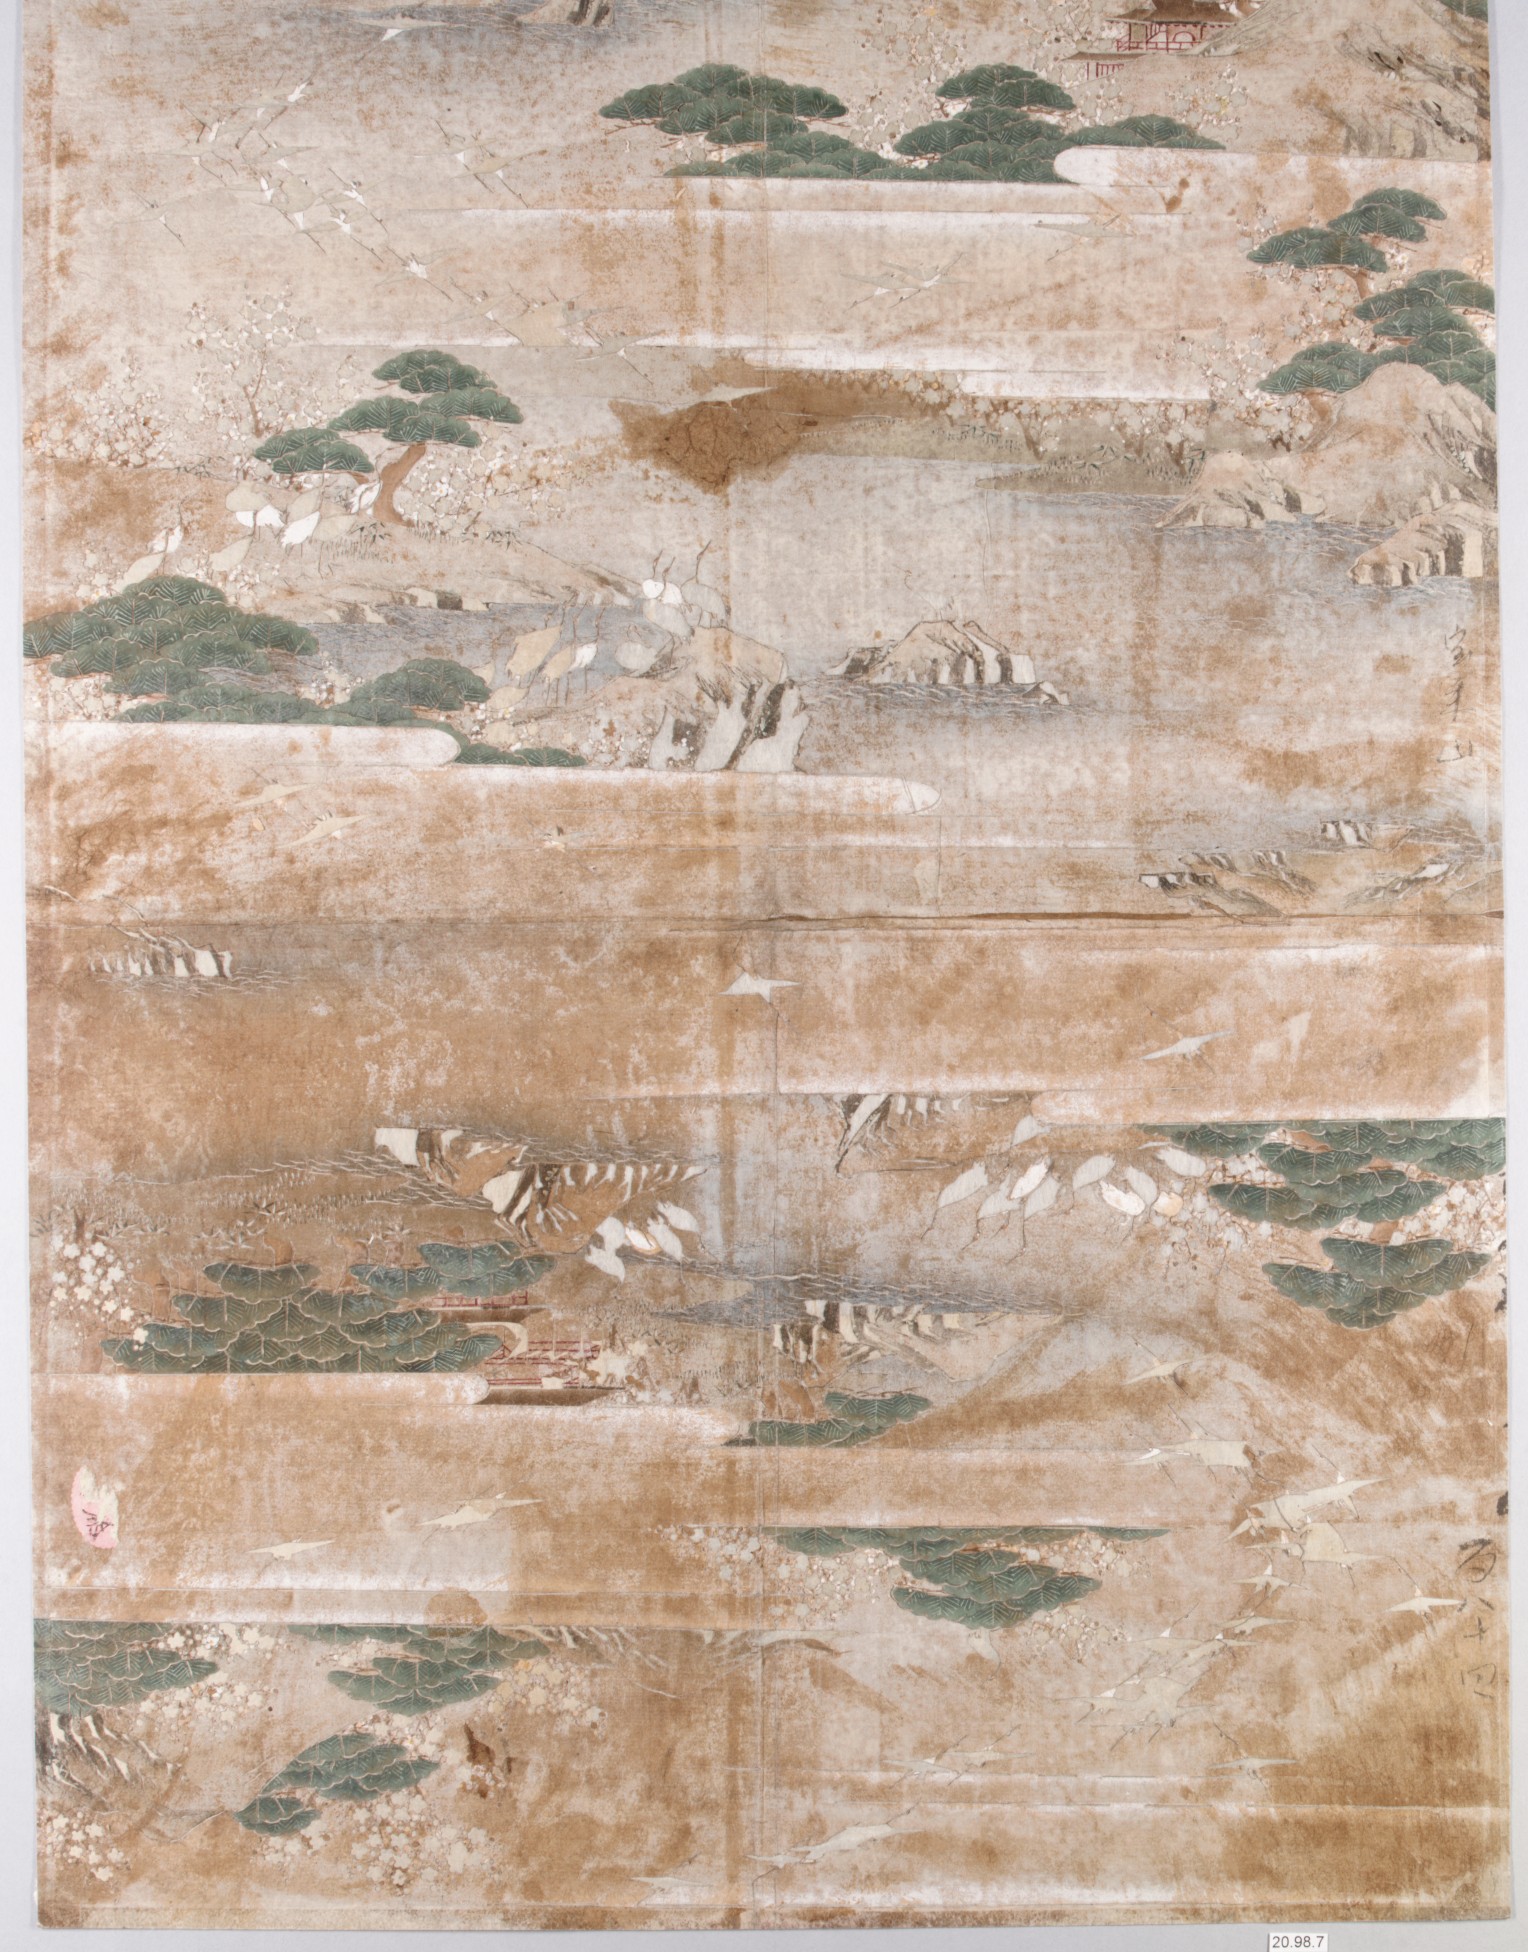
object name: textile design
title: Textile Design for Stencil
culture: japanese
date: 1601-1700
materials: paint, paper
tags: landscapes